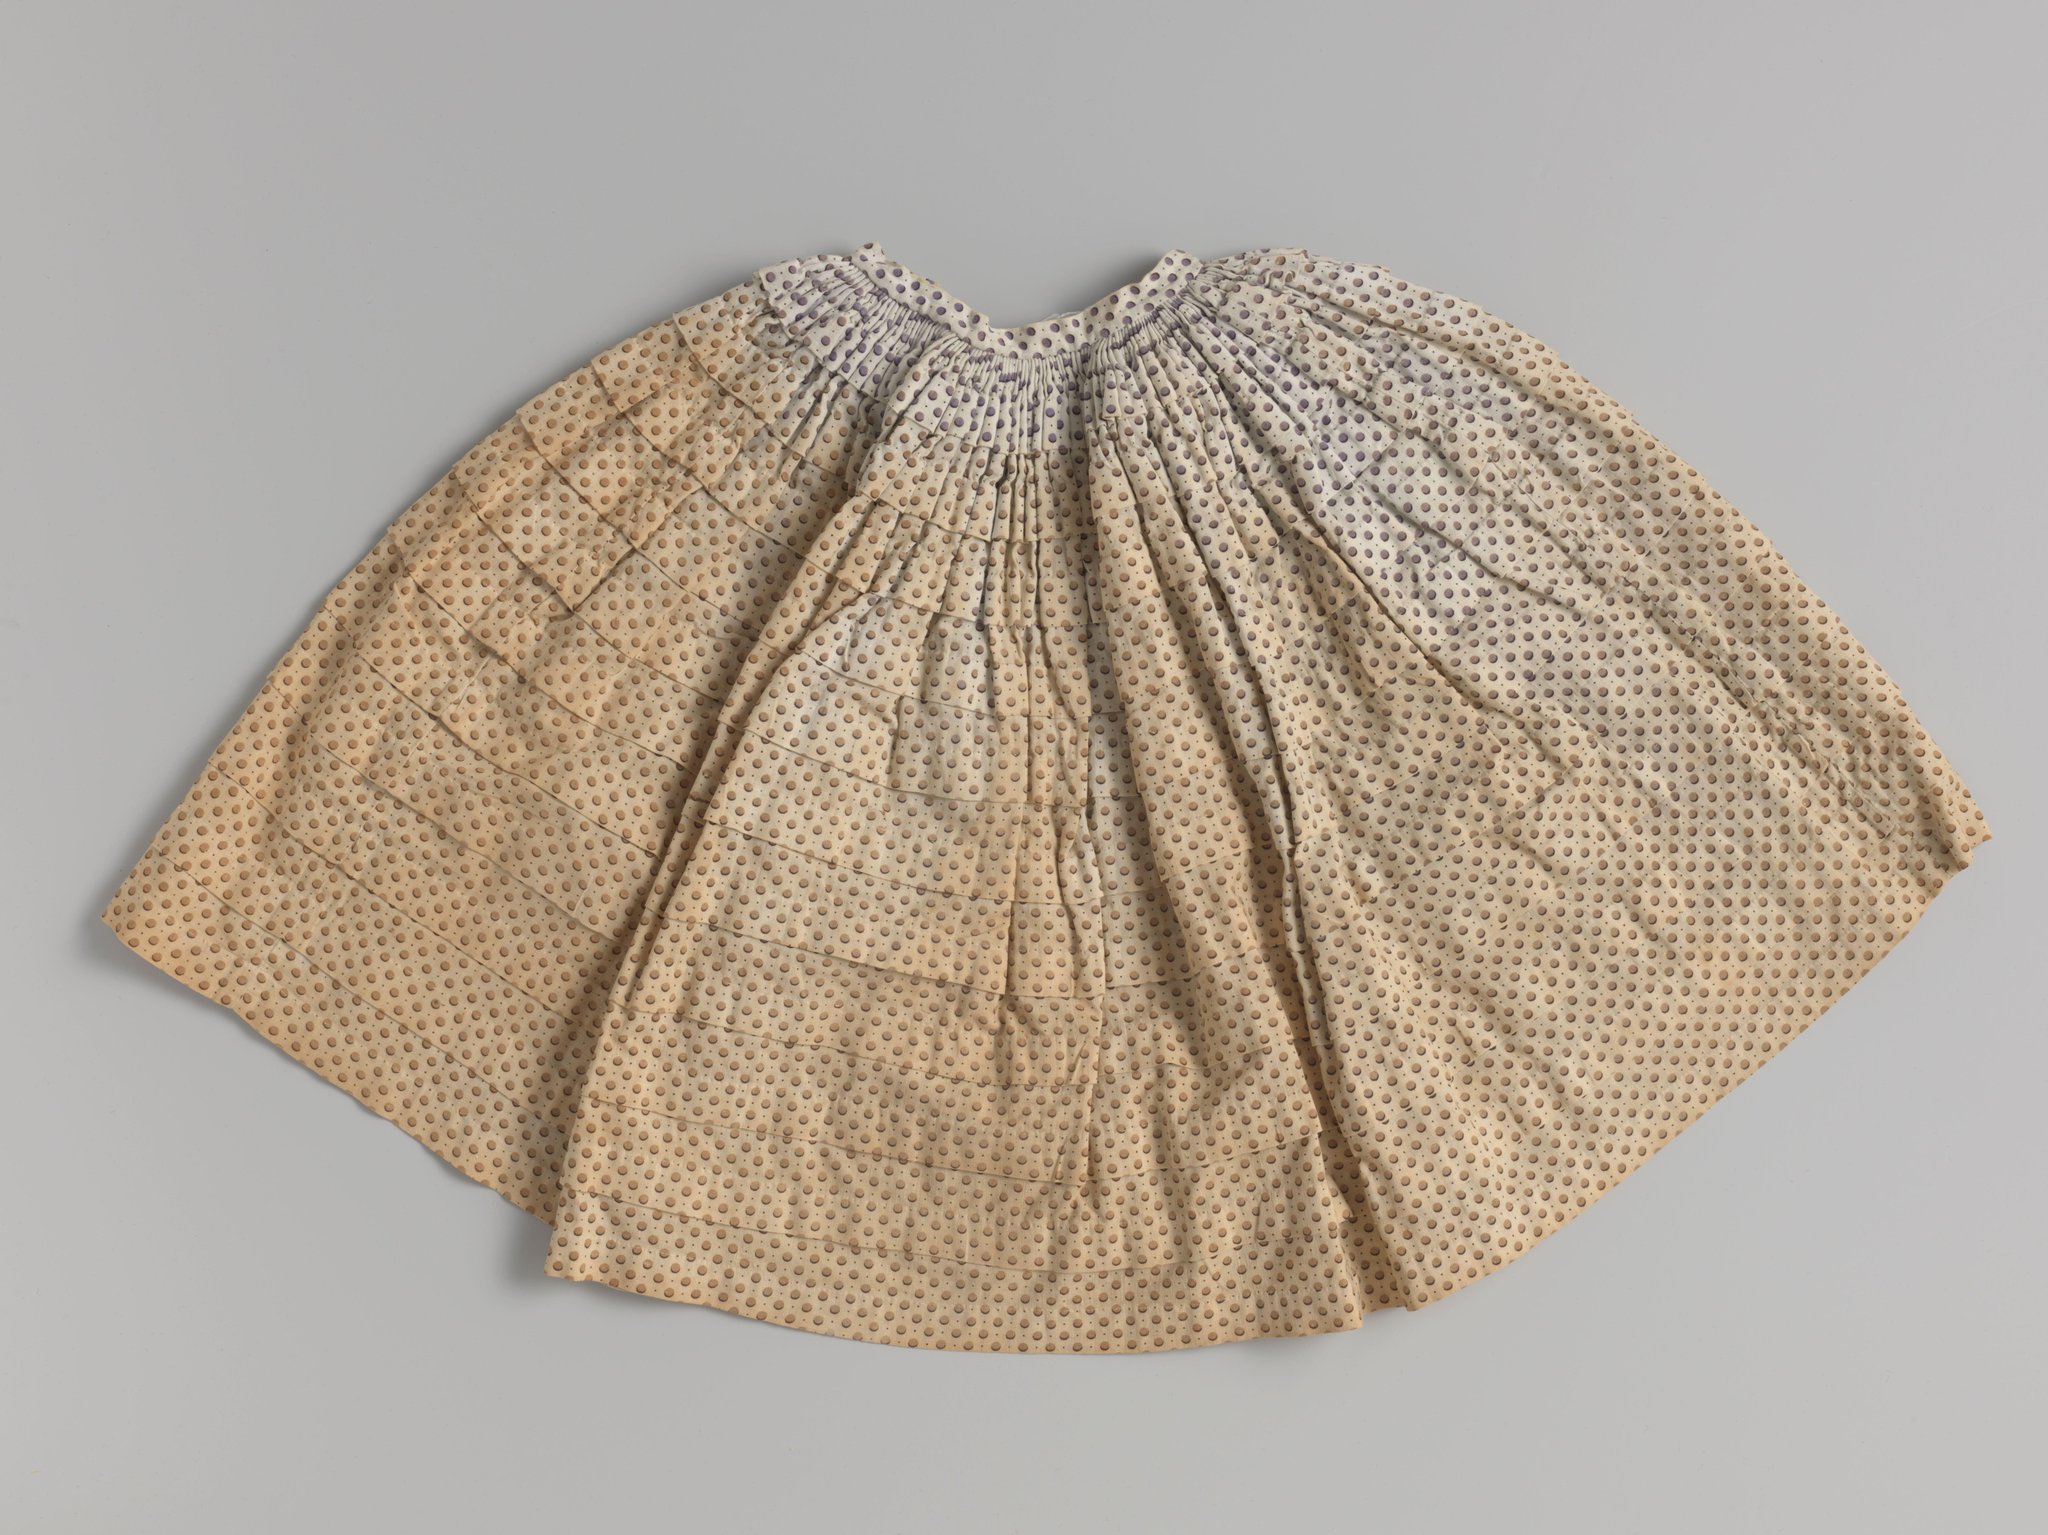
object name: doll's clothing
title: Rok of crinoline met stippen en tien oprijgen.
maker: Anonymous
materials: cotton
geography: netherlands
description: Rokof crinoline met paarse stippen en tien oprijgen.